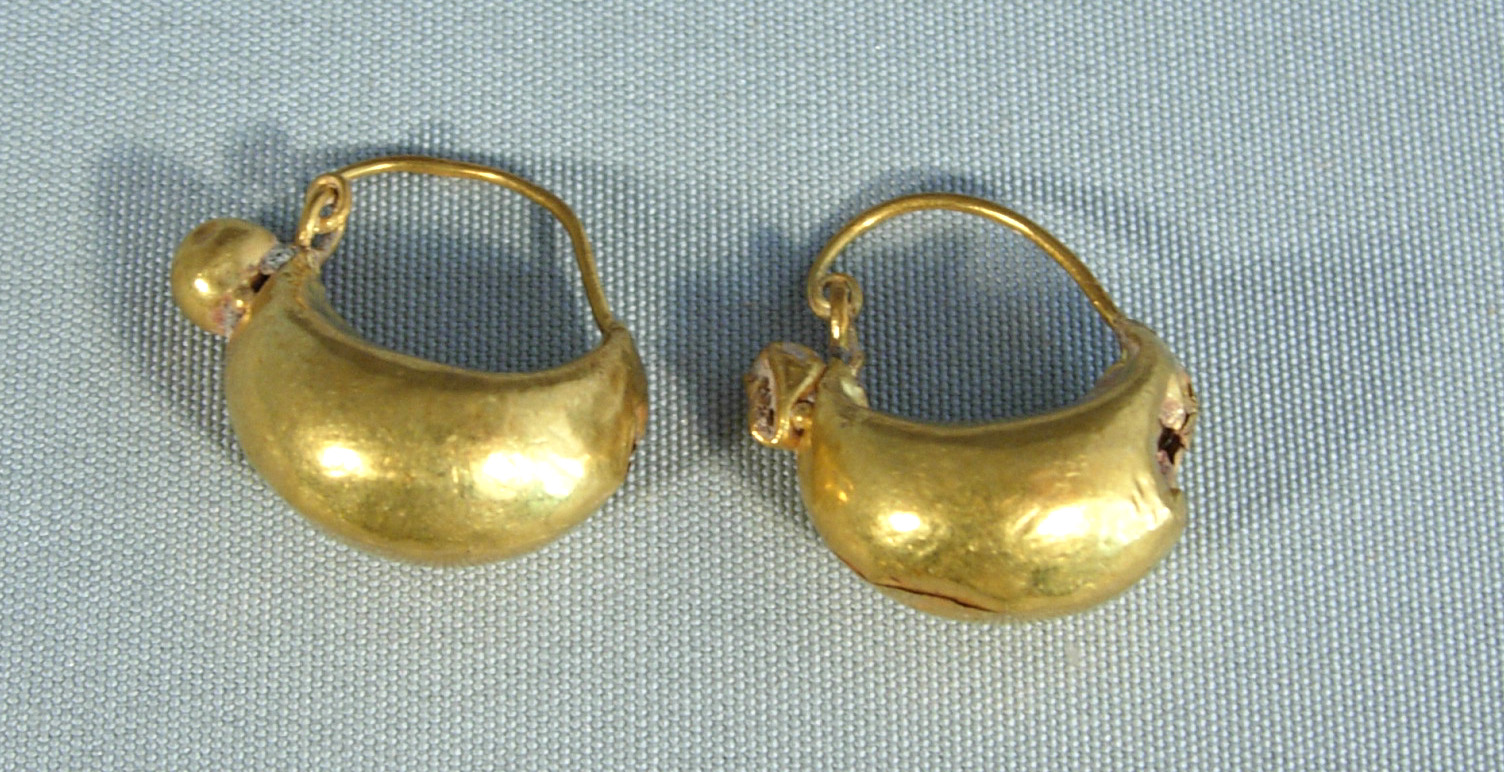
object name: pair of boat shaped earring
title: Pair of gold boat-shaped earrings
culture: roman, asia minor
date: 1-100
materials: gold